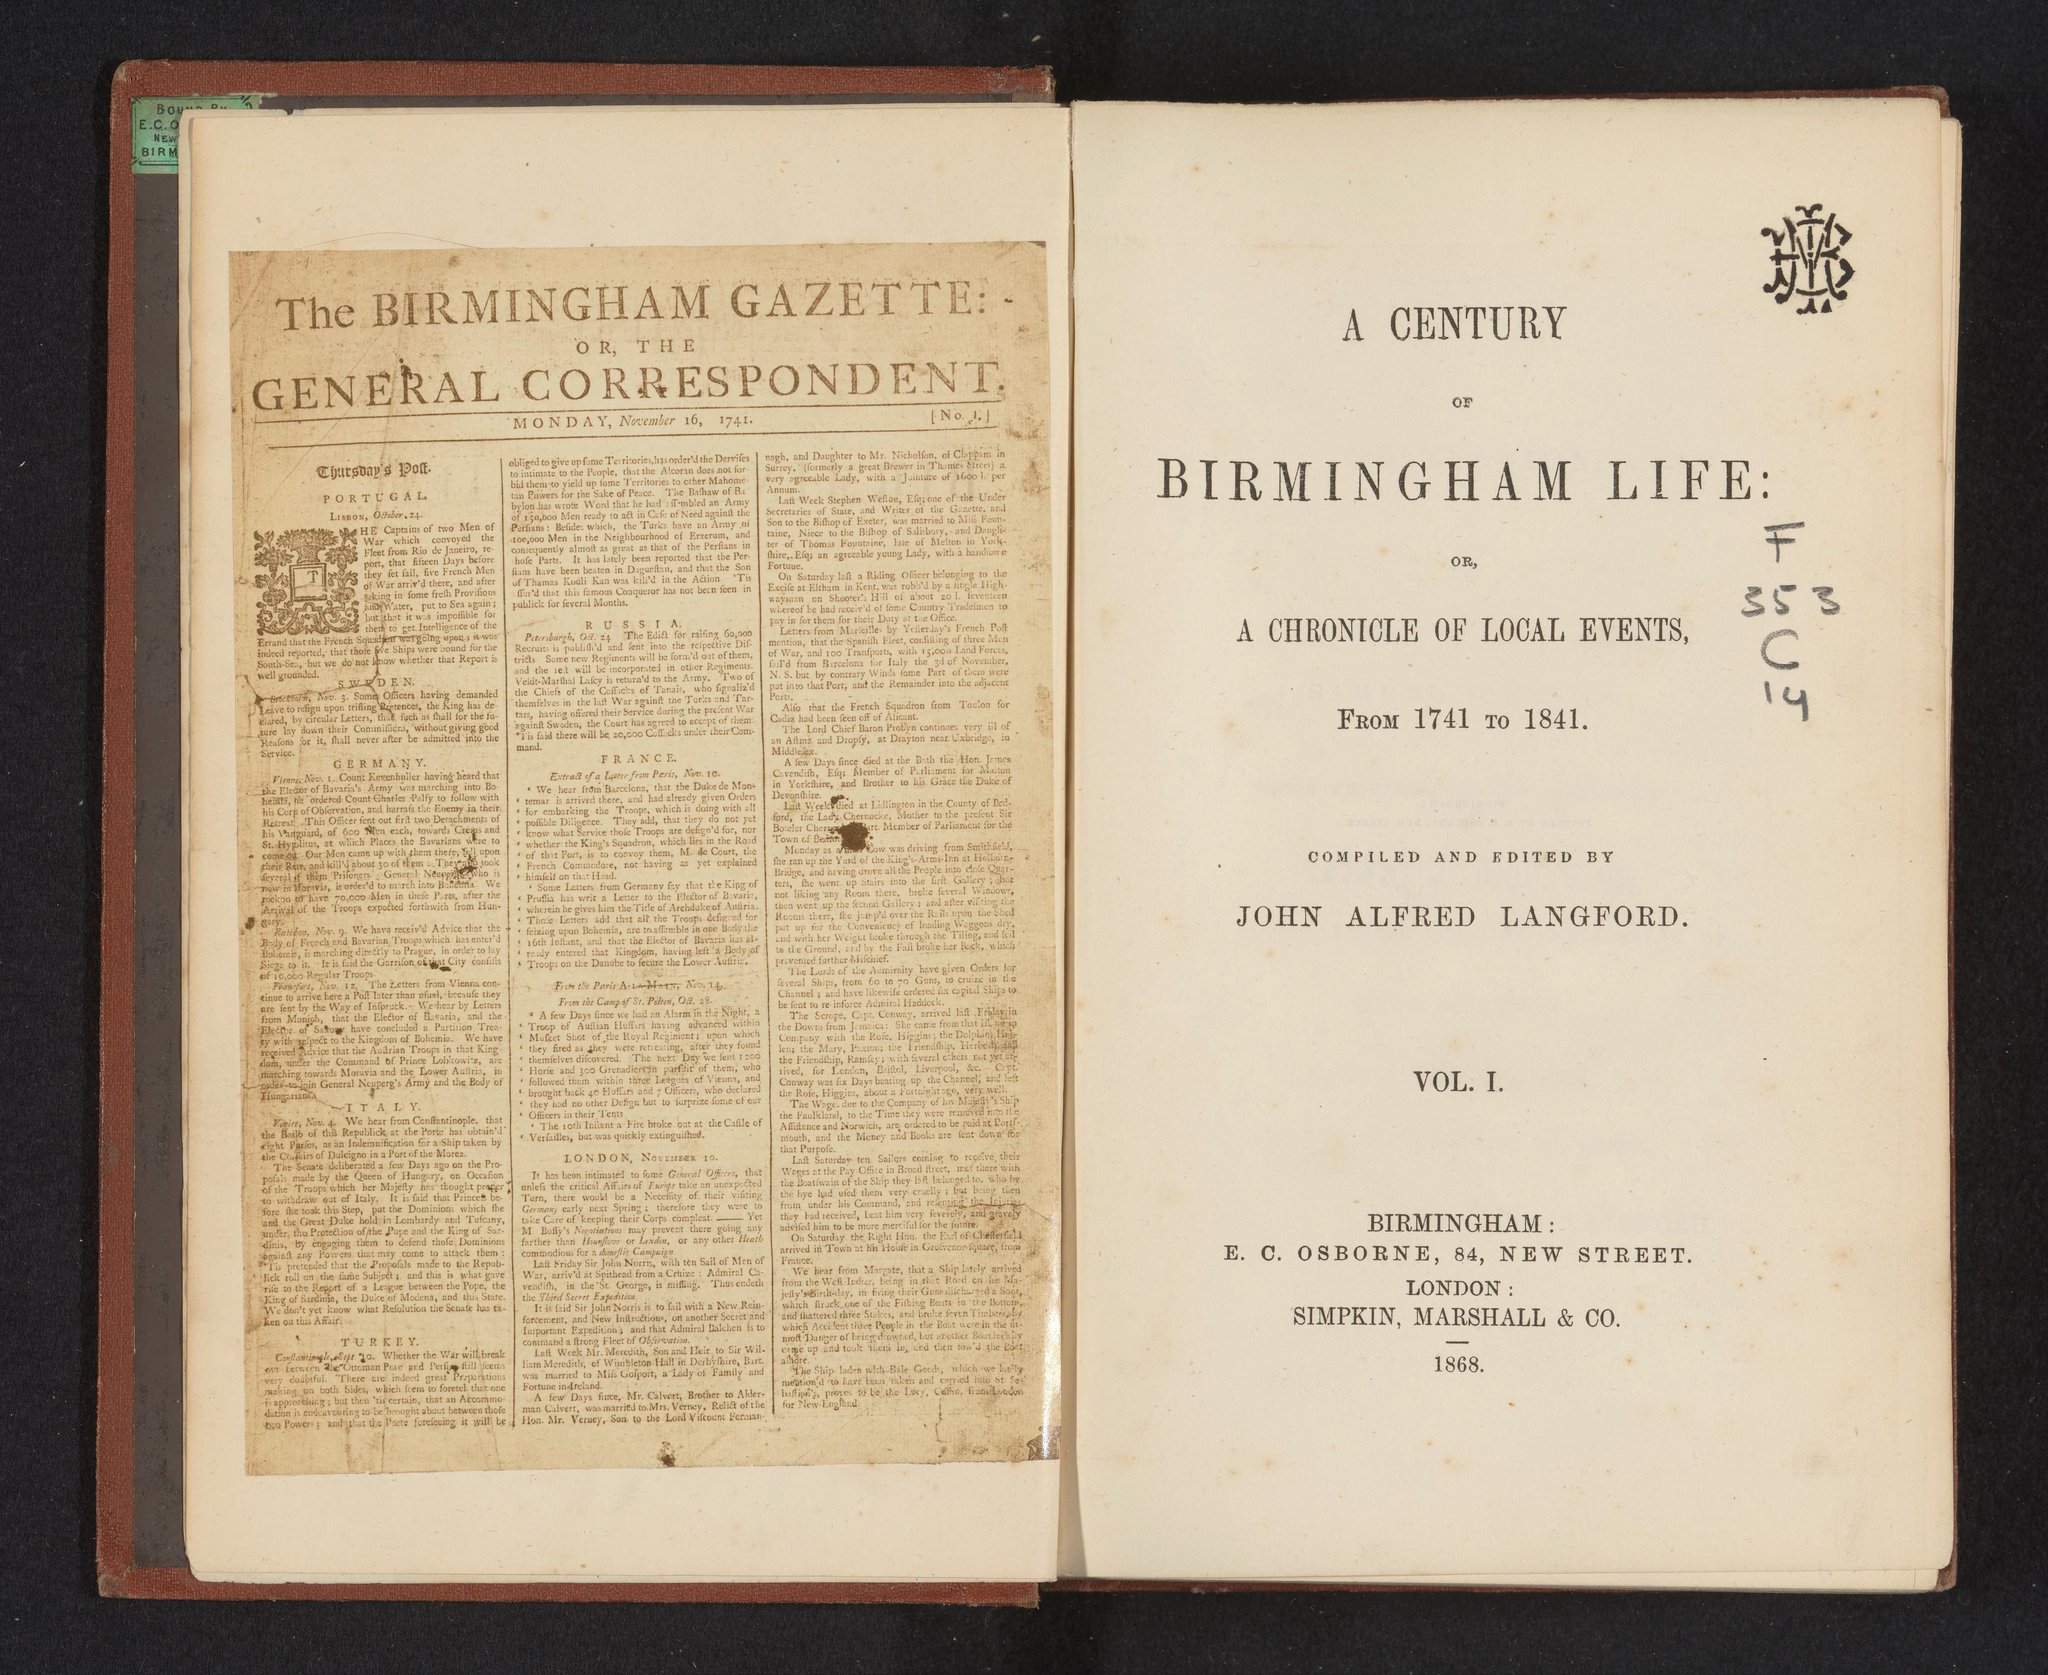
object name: page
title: Fotoreproductie van de voorpagina van de eerste Birmingham Gazette, gepubliceerd op 16 november 1741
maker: henry joseph whitlock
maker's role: fotograaf, hofleverancier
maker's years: 1835-1918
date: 1858-1868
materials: photographic support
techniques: albumen print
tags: newspaper, news-sheet